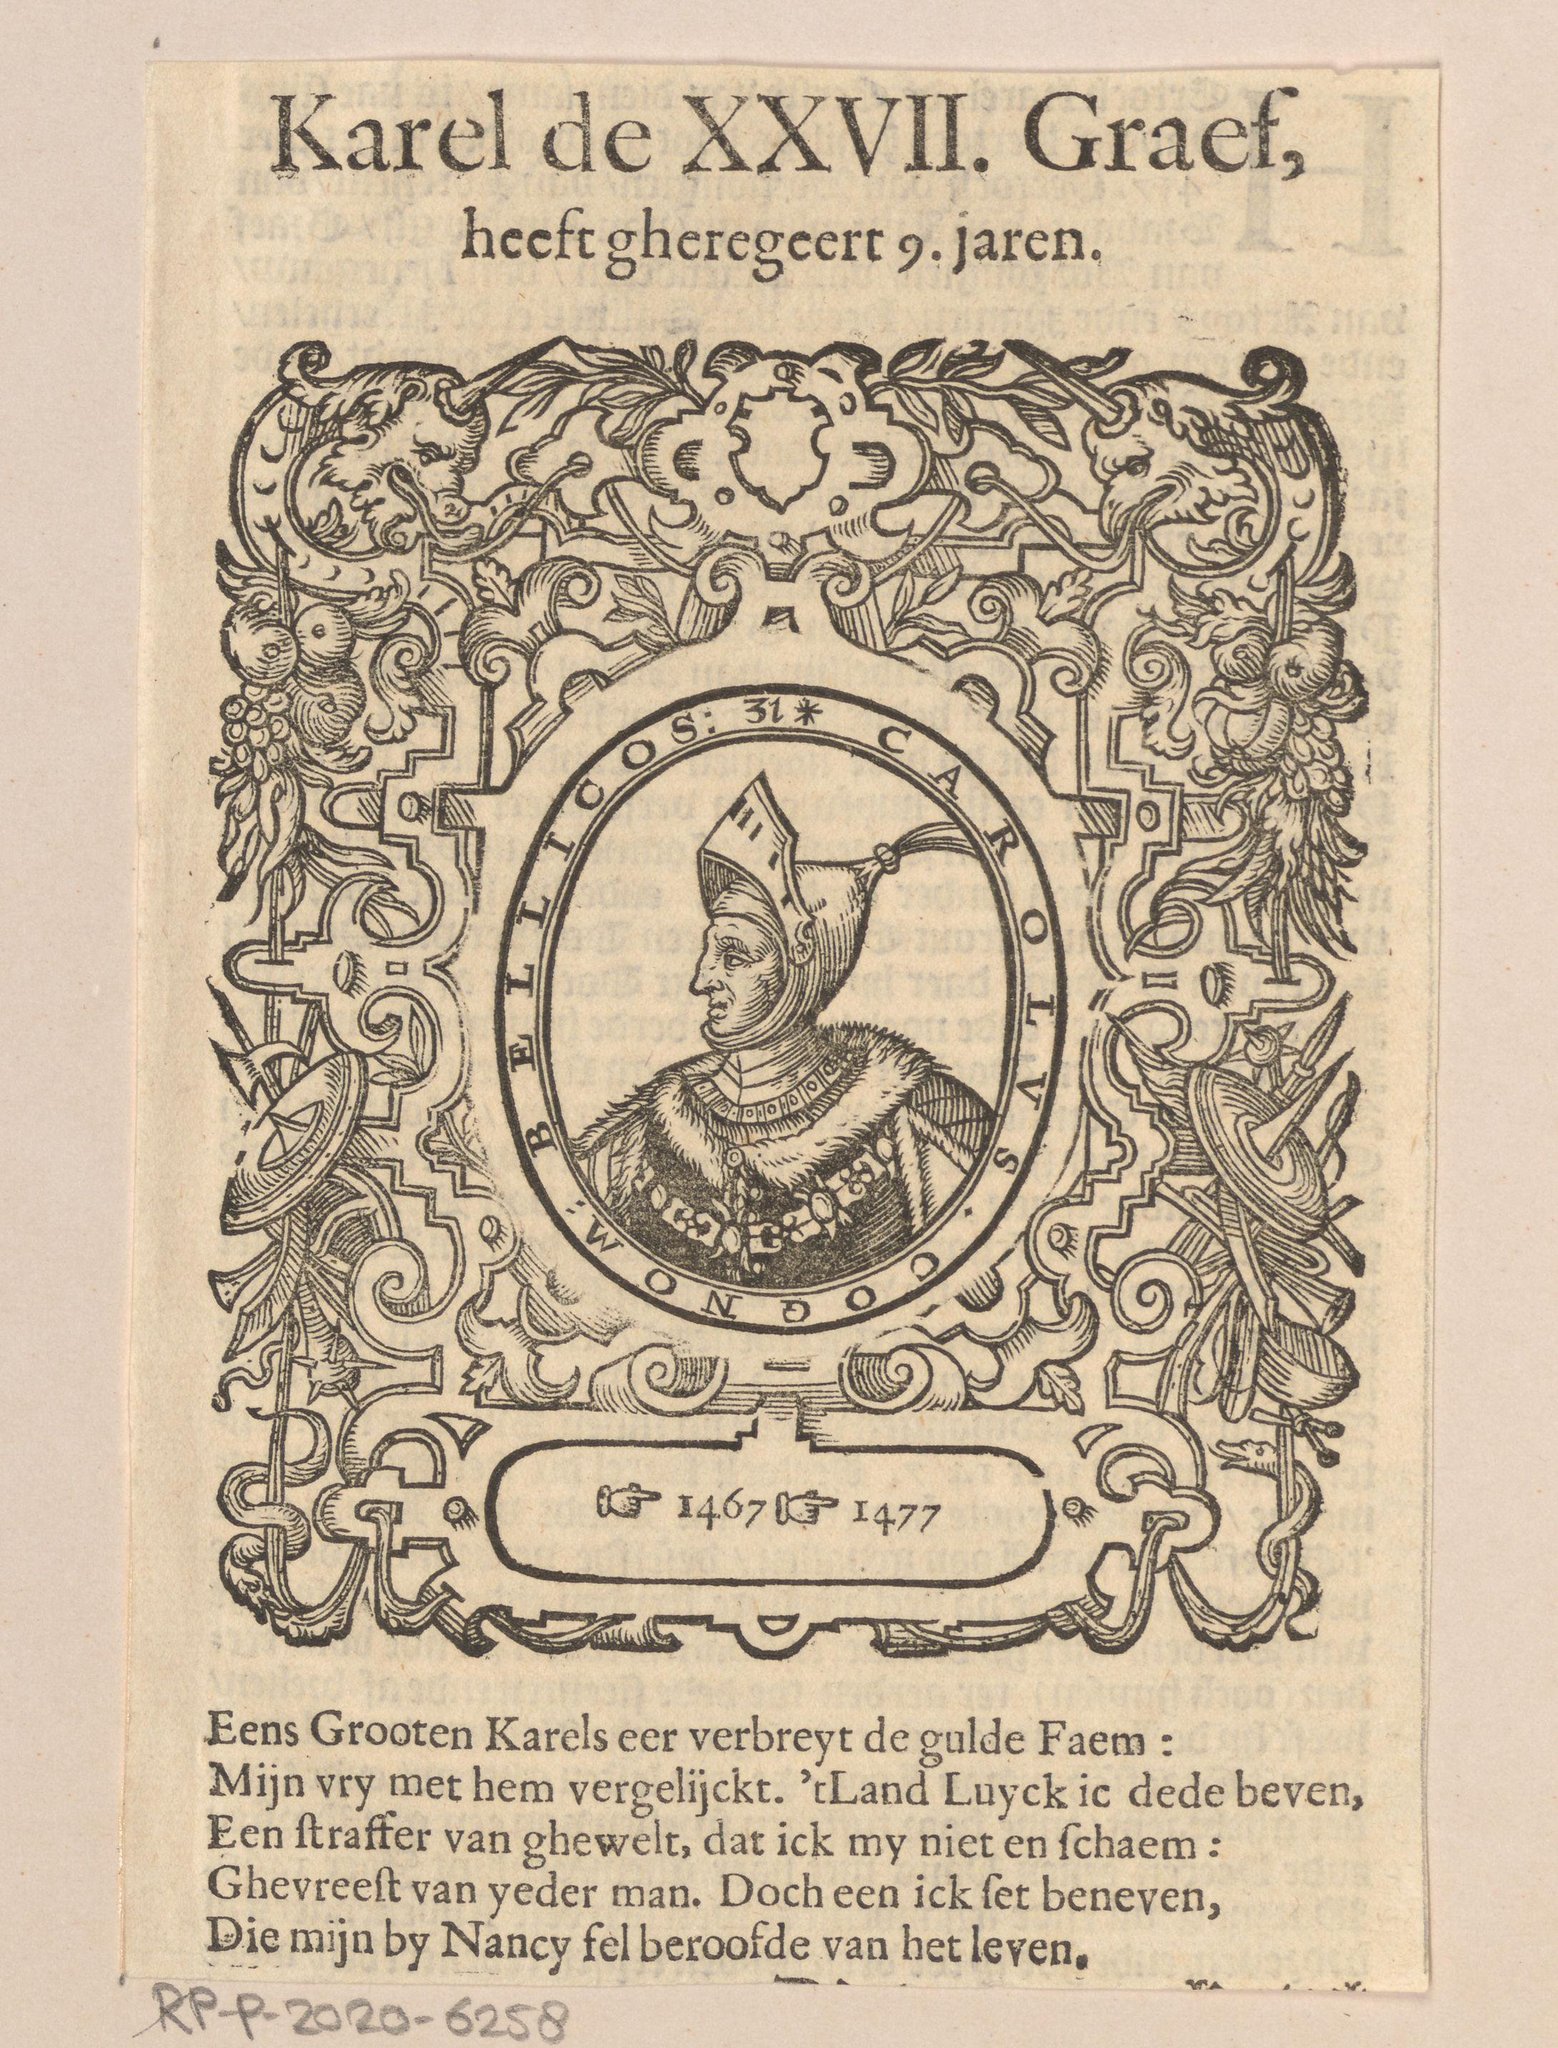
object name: book illustration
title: Portret van Karel de Stoute, hertog van Bourgondië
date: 1636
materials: paper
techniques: letterpress printing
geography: amsterdam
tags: earl, charles the bold (duke of burgundy), historical persons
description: Prent uit: Scriverius, Petrus. Beschrivinge van Out Batavien (...). Amsterdam: Jan Evertsz Cloppenburgh II, 1636, p. 409.